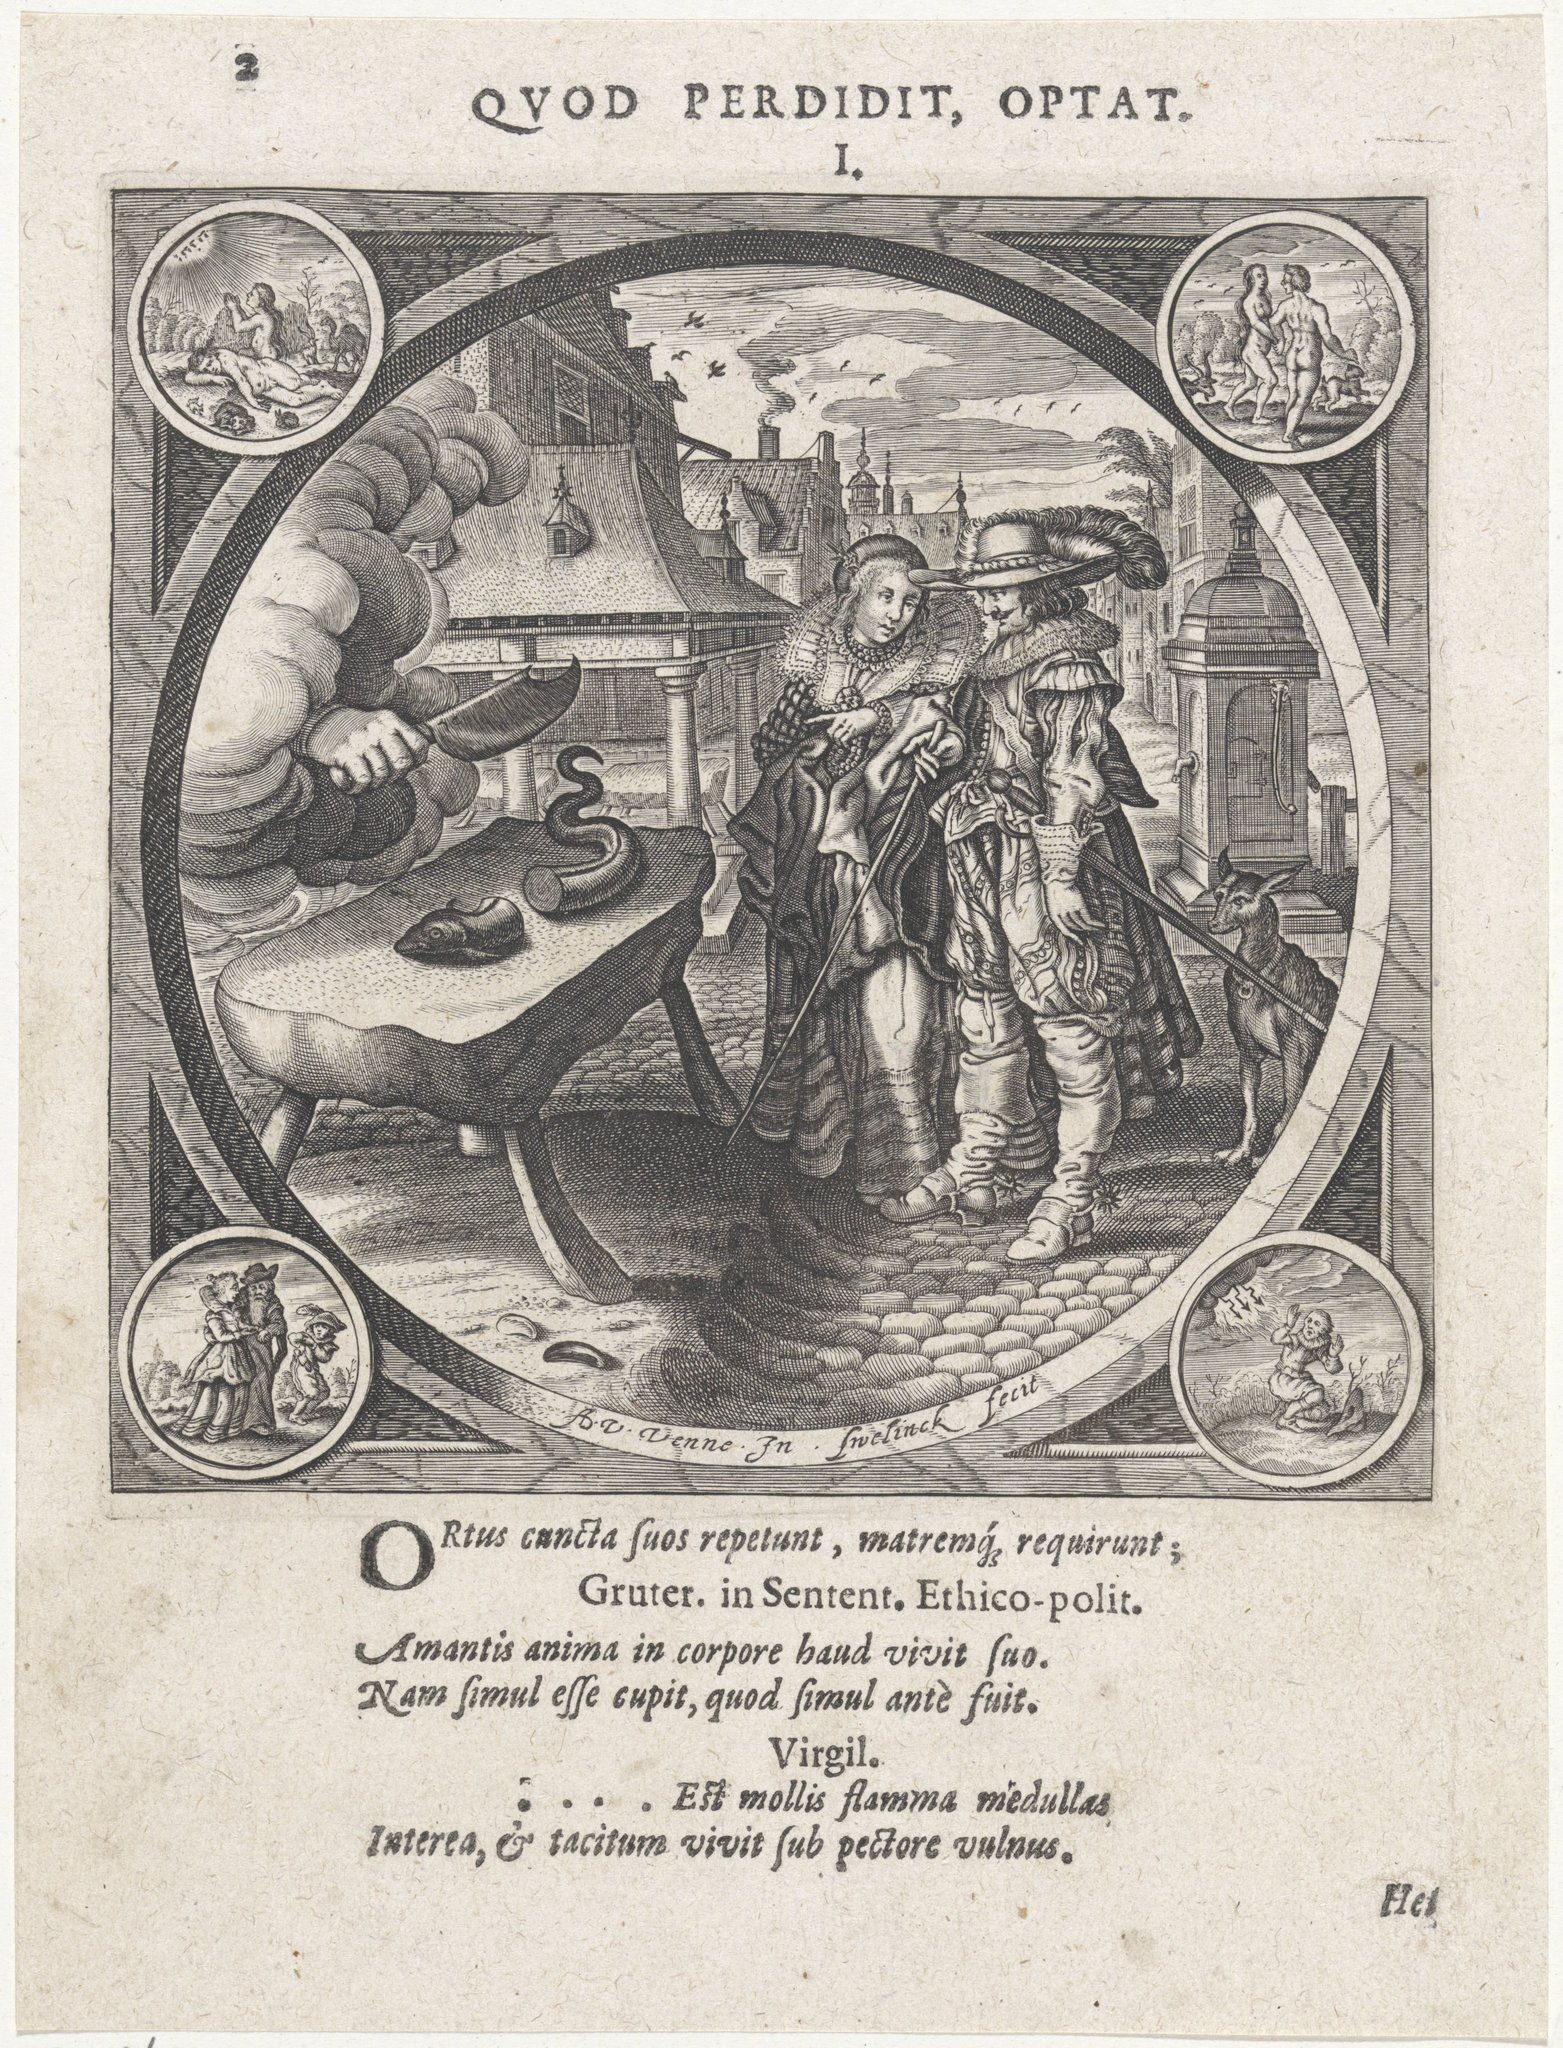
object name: book illustration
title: Man en vrouw op vismarkt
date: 1627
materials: paper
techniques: engraving, letterpress printing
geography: amsterdam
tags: utilitarian, public pump or water fountain, marketing, shopping (~ household management), violent death by beheading, market-hall, eels: eel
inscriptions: collector's mark: Lugt 2228, collector's mark: Lugt 2760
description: Een man en vrouw, beiden rijk gekleed en vergezeld door een hond, kijken naar een tafel met daarop een kronkelende paling waarvan de kop is afgehakt. Uit een wolk steekt een hand met een hakmes. Op de achtergrond een stadsgezicht met markthal en waterpomp. Op de vier hoeken een vignet: boven twee afbeeldingen met Adam en Eva, linksonder een vrouw met een grijsaard en een jongen en rechtsonder een man die ineenkrimpt voor een bliksemschicht. Onder de prent in boekdruk verzen in het Latijn, er boven de titel van het embleem.